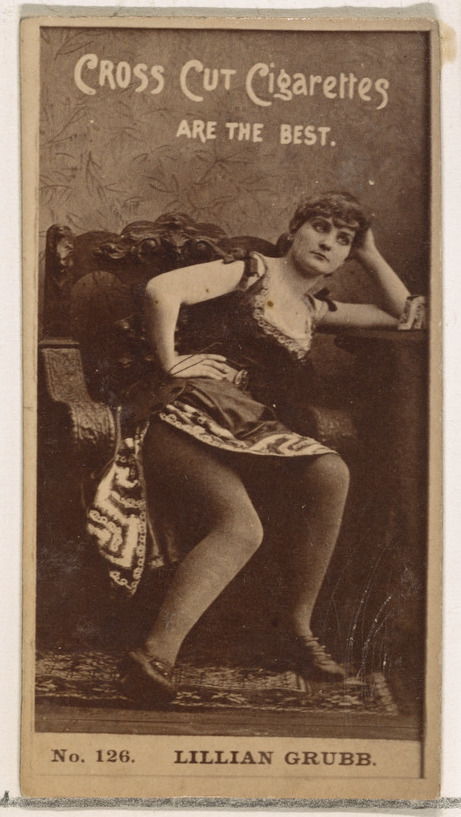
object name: print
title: Card Number 126, Lillian Grubb, from the Actors and Actresses series (N145-2) issued by Duke Sons & Co. to promote Cross Cut Cigarettes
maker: w. duke, sons & co.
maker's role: publisher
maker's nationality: american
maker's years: 1870-1920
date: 1880-1889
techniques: albumen silver print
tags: portraits,women,actresses